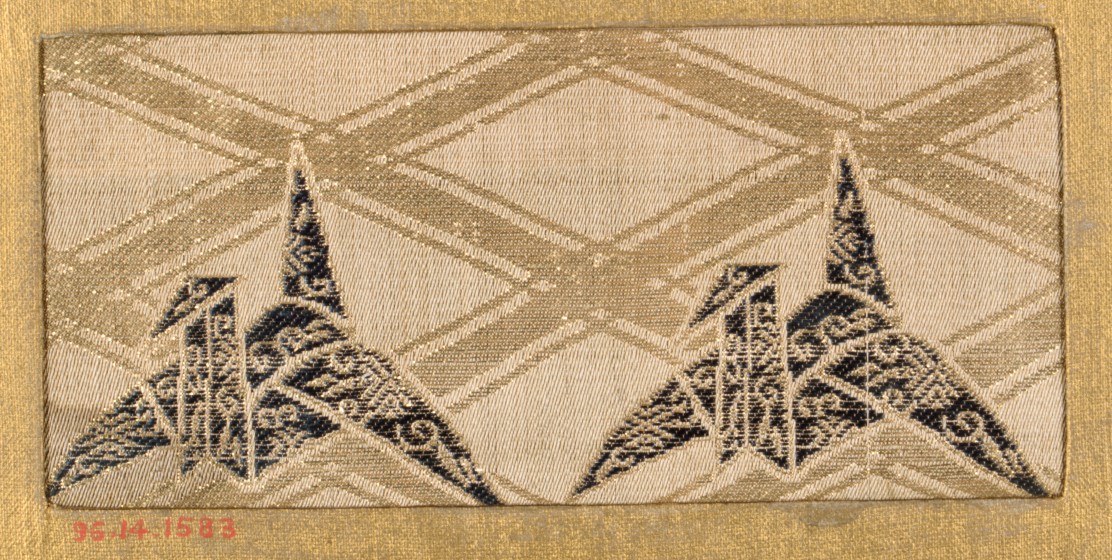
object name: piece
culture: japanese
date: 1701-1900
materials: silk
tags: cranes